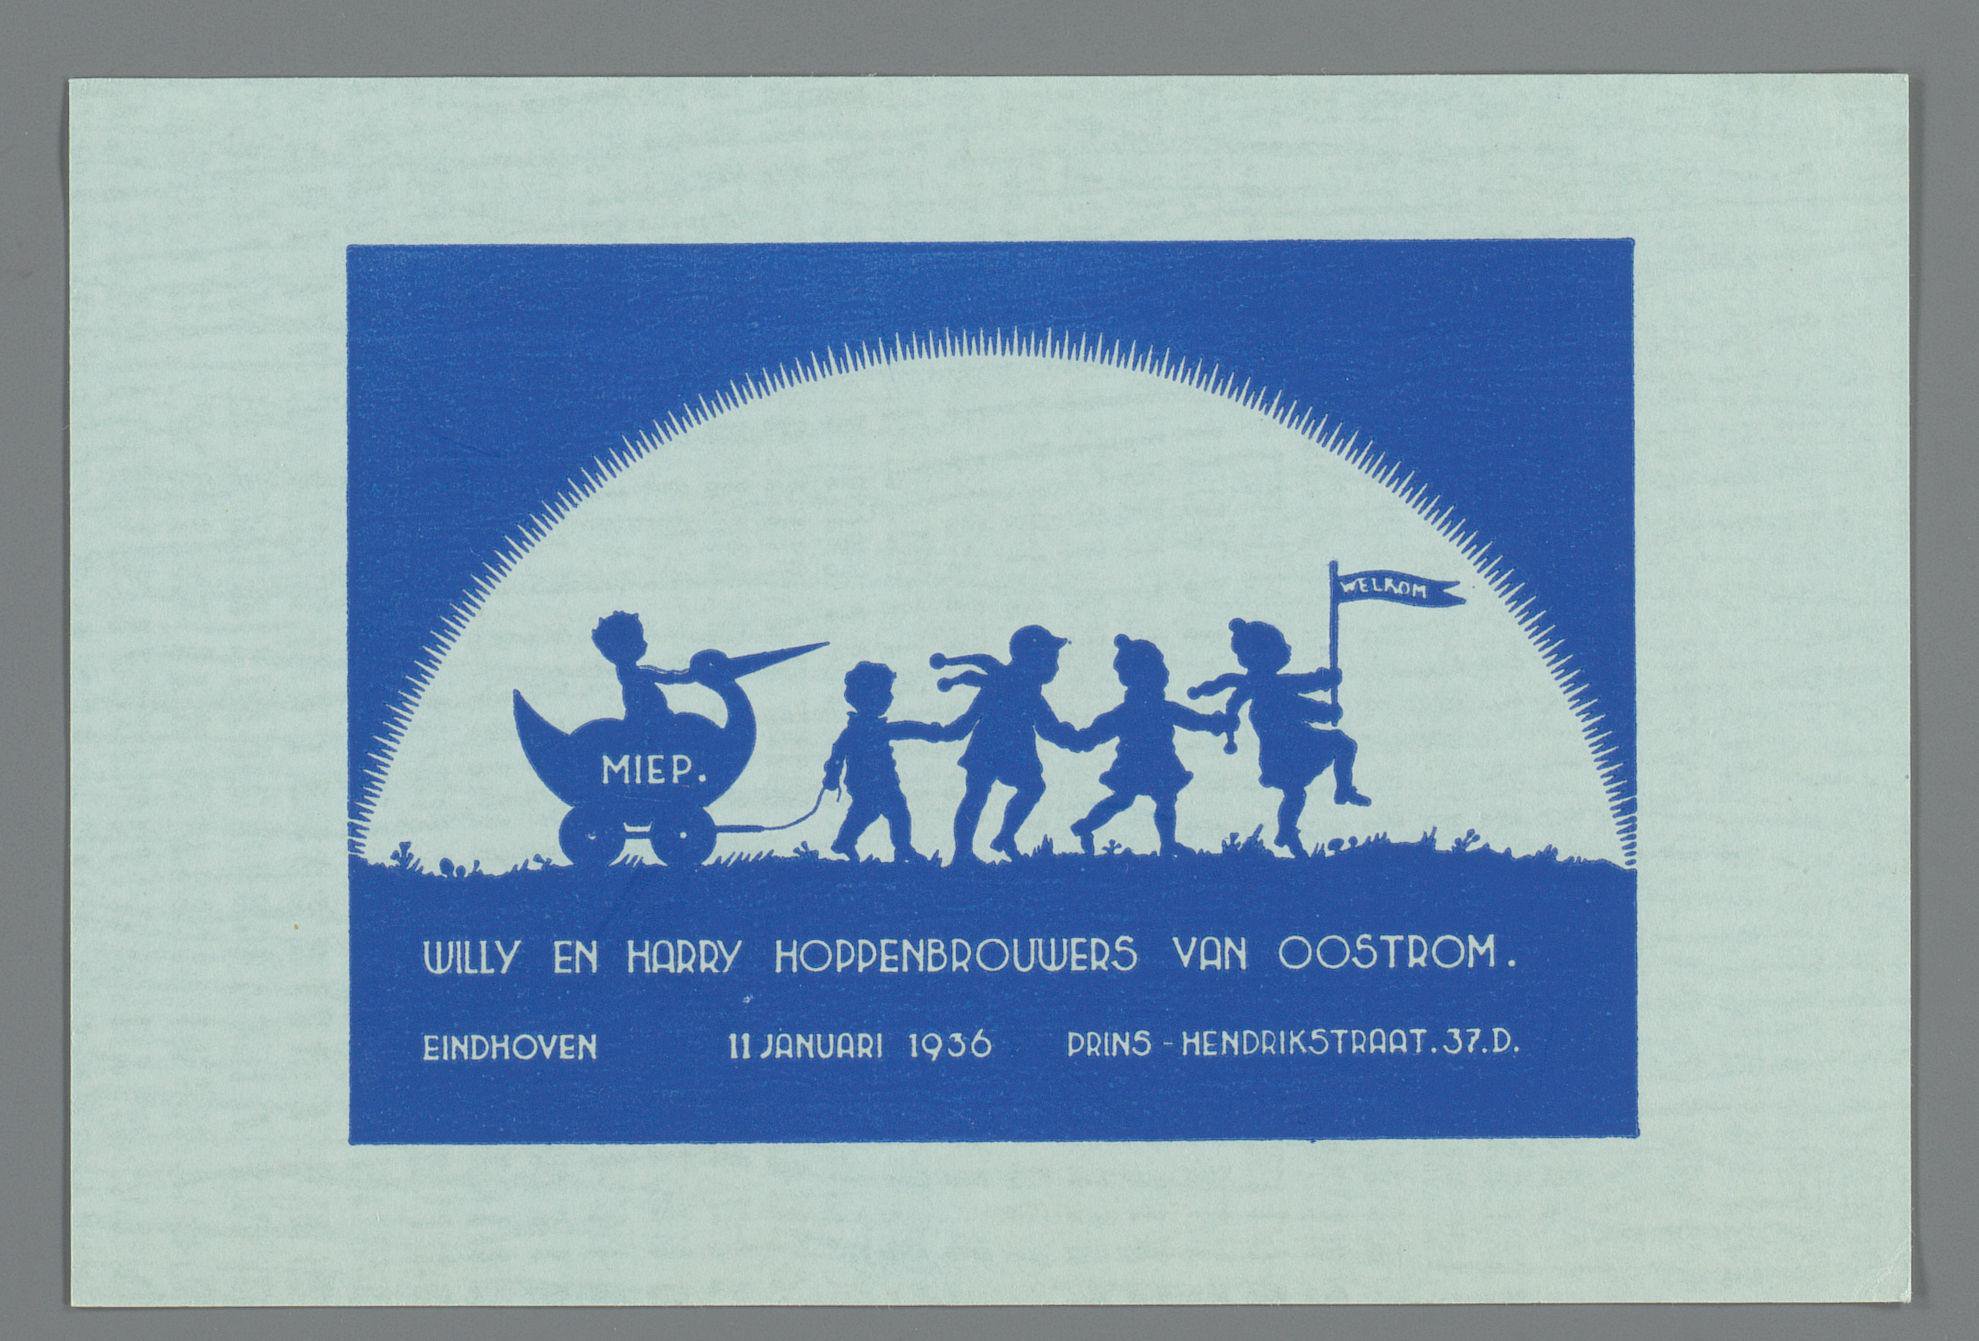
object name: photomechanical print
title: Geboortekaart voor Miep Hoppenbrouwers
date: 1936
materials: paper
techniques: printing block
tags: children's games and plays, announcement of birth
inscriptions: annotation: ‘Eigen ontw. HH’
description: Een groep van vier kinderen, de voorste met een vlag met 'welkom', trekken een ooievaar op wielen voort met daarop een vijfde kind; op de borst van de ooievaar de naam Miep. Daaronder: 'Willy en Harry Hoppenbrouwers van Oostrom. Eindhoven 11 januari 1936' gevolgd door het adres van de afzenders.